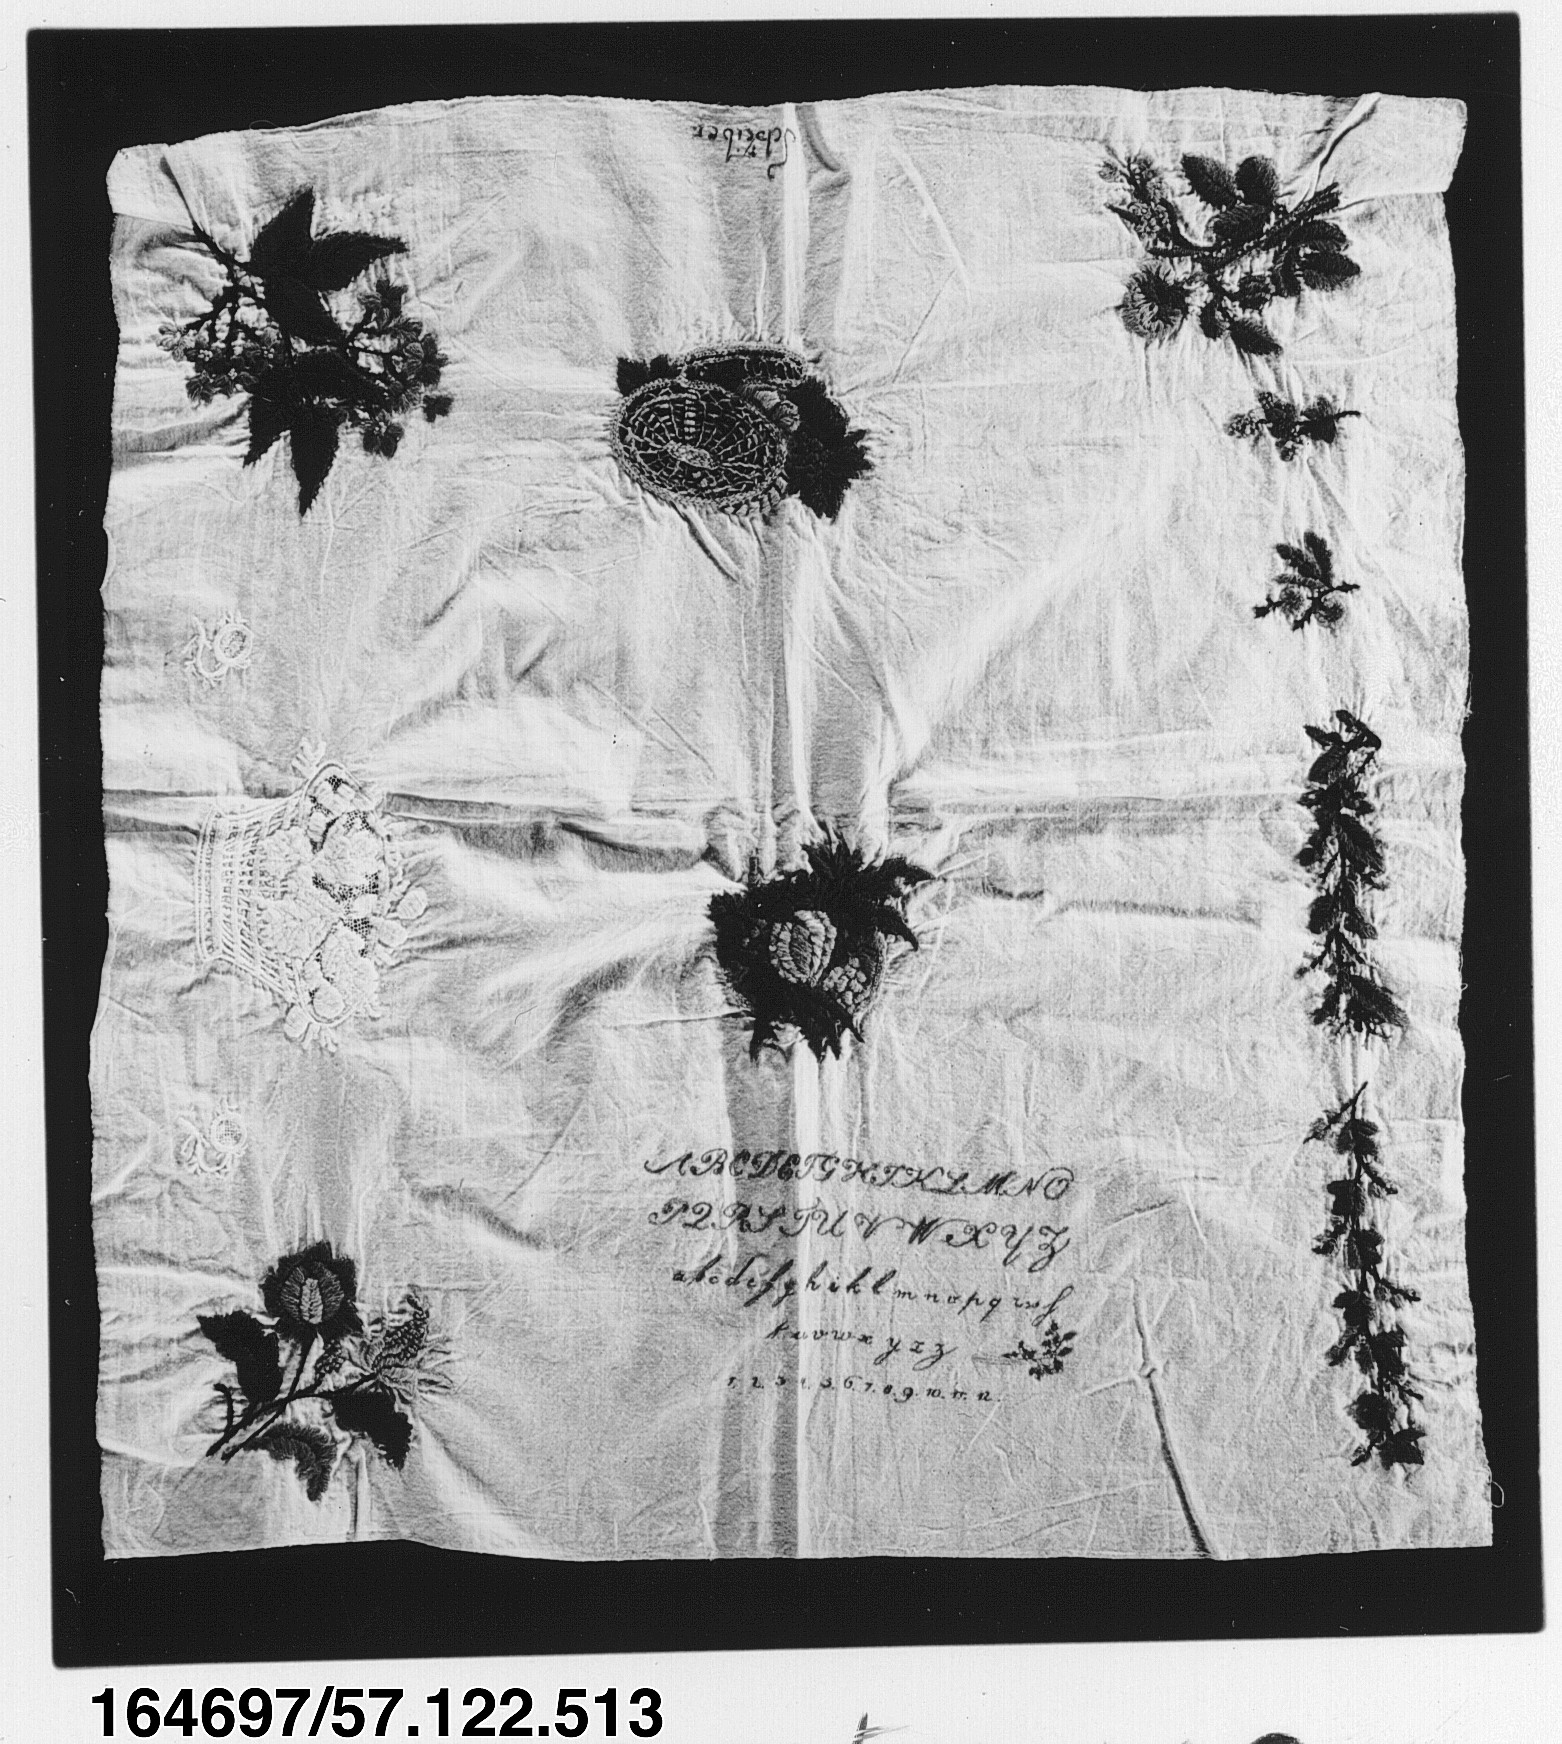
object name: sampler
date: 1801-1900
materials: cotton, wool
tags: flowers